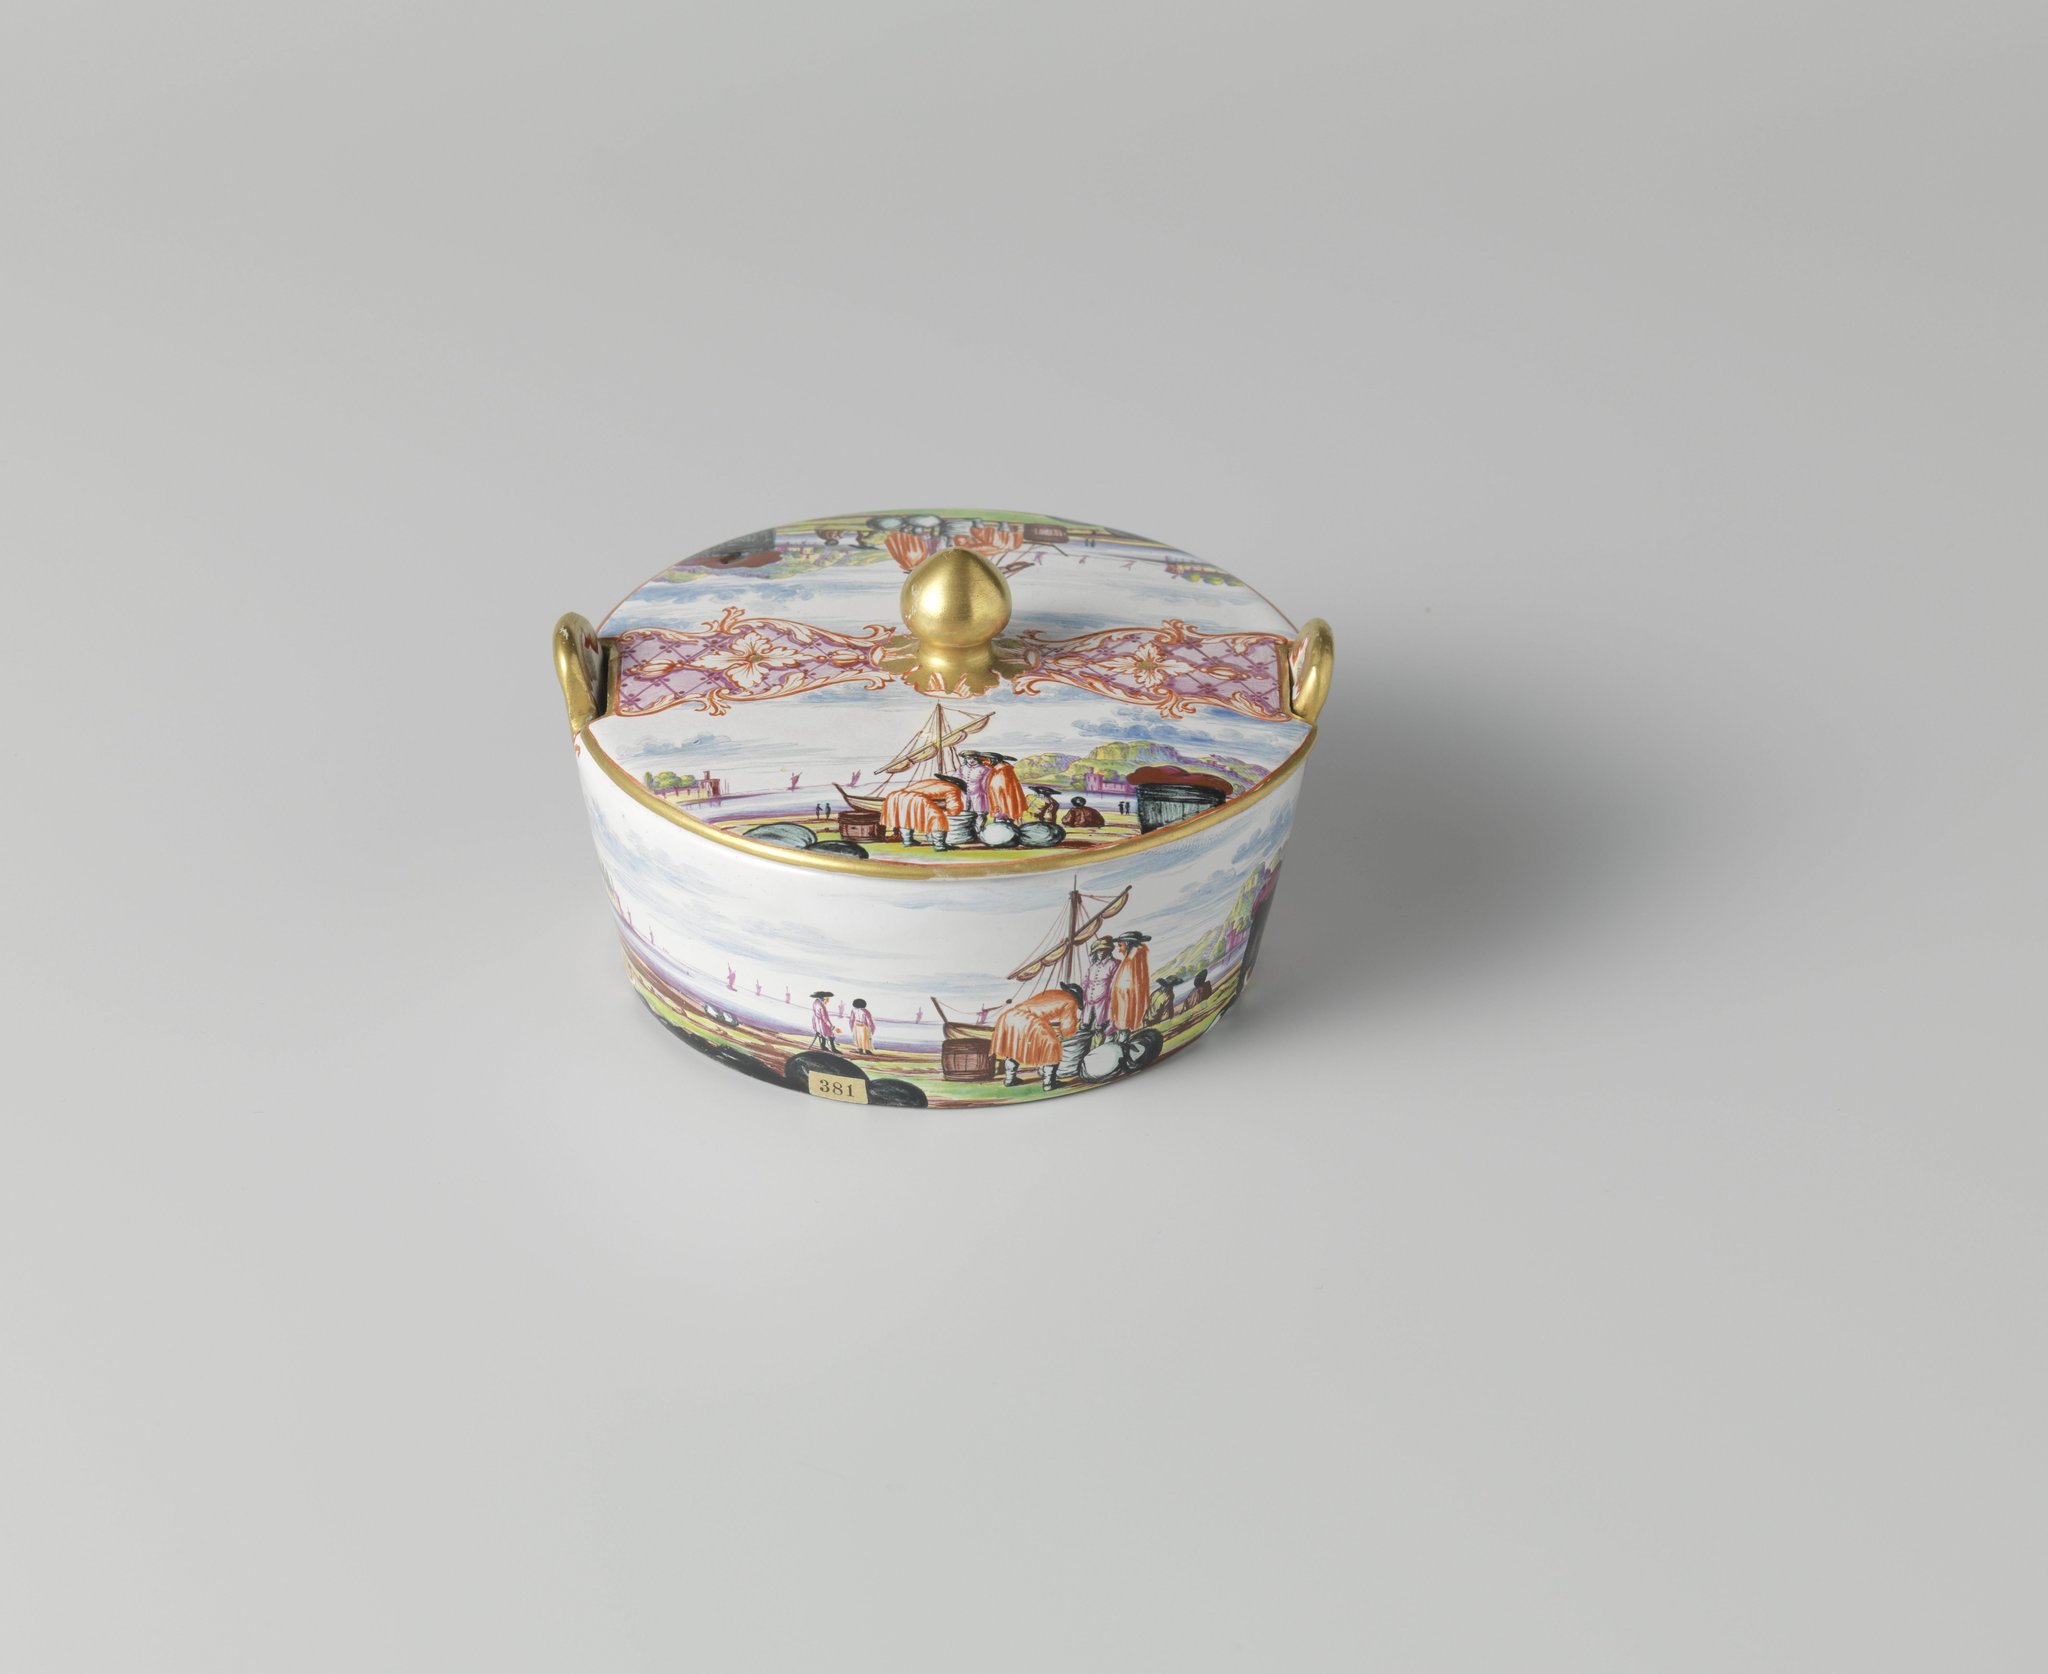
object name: butter dish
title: Ronde botervloot van faïence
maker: Anonymous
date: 1740-1765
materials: faience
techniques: kiln, painted, polychromy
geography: delft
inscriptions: collector's mark: ‘collection J.F. Loudon’, inscription: ‘10’, inscription: ‘10’, mark: ‘VA’, inscription: ‘Goet’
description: Ronde botervloot met opstaande oortjes veelkleurig beschilderd met een mediterraan landschap. Gemerkt in blauw VA.